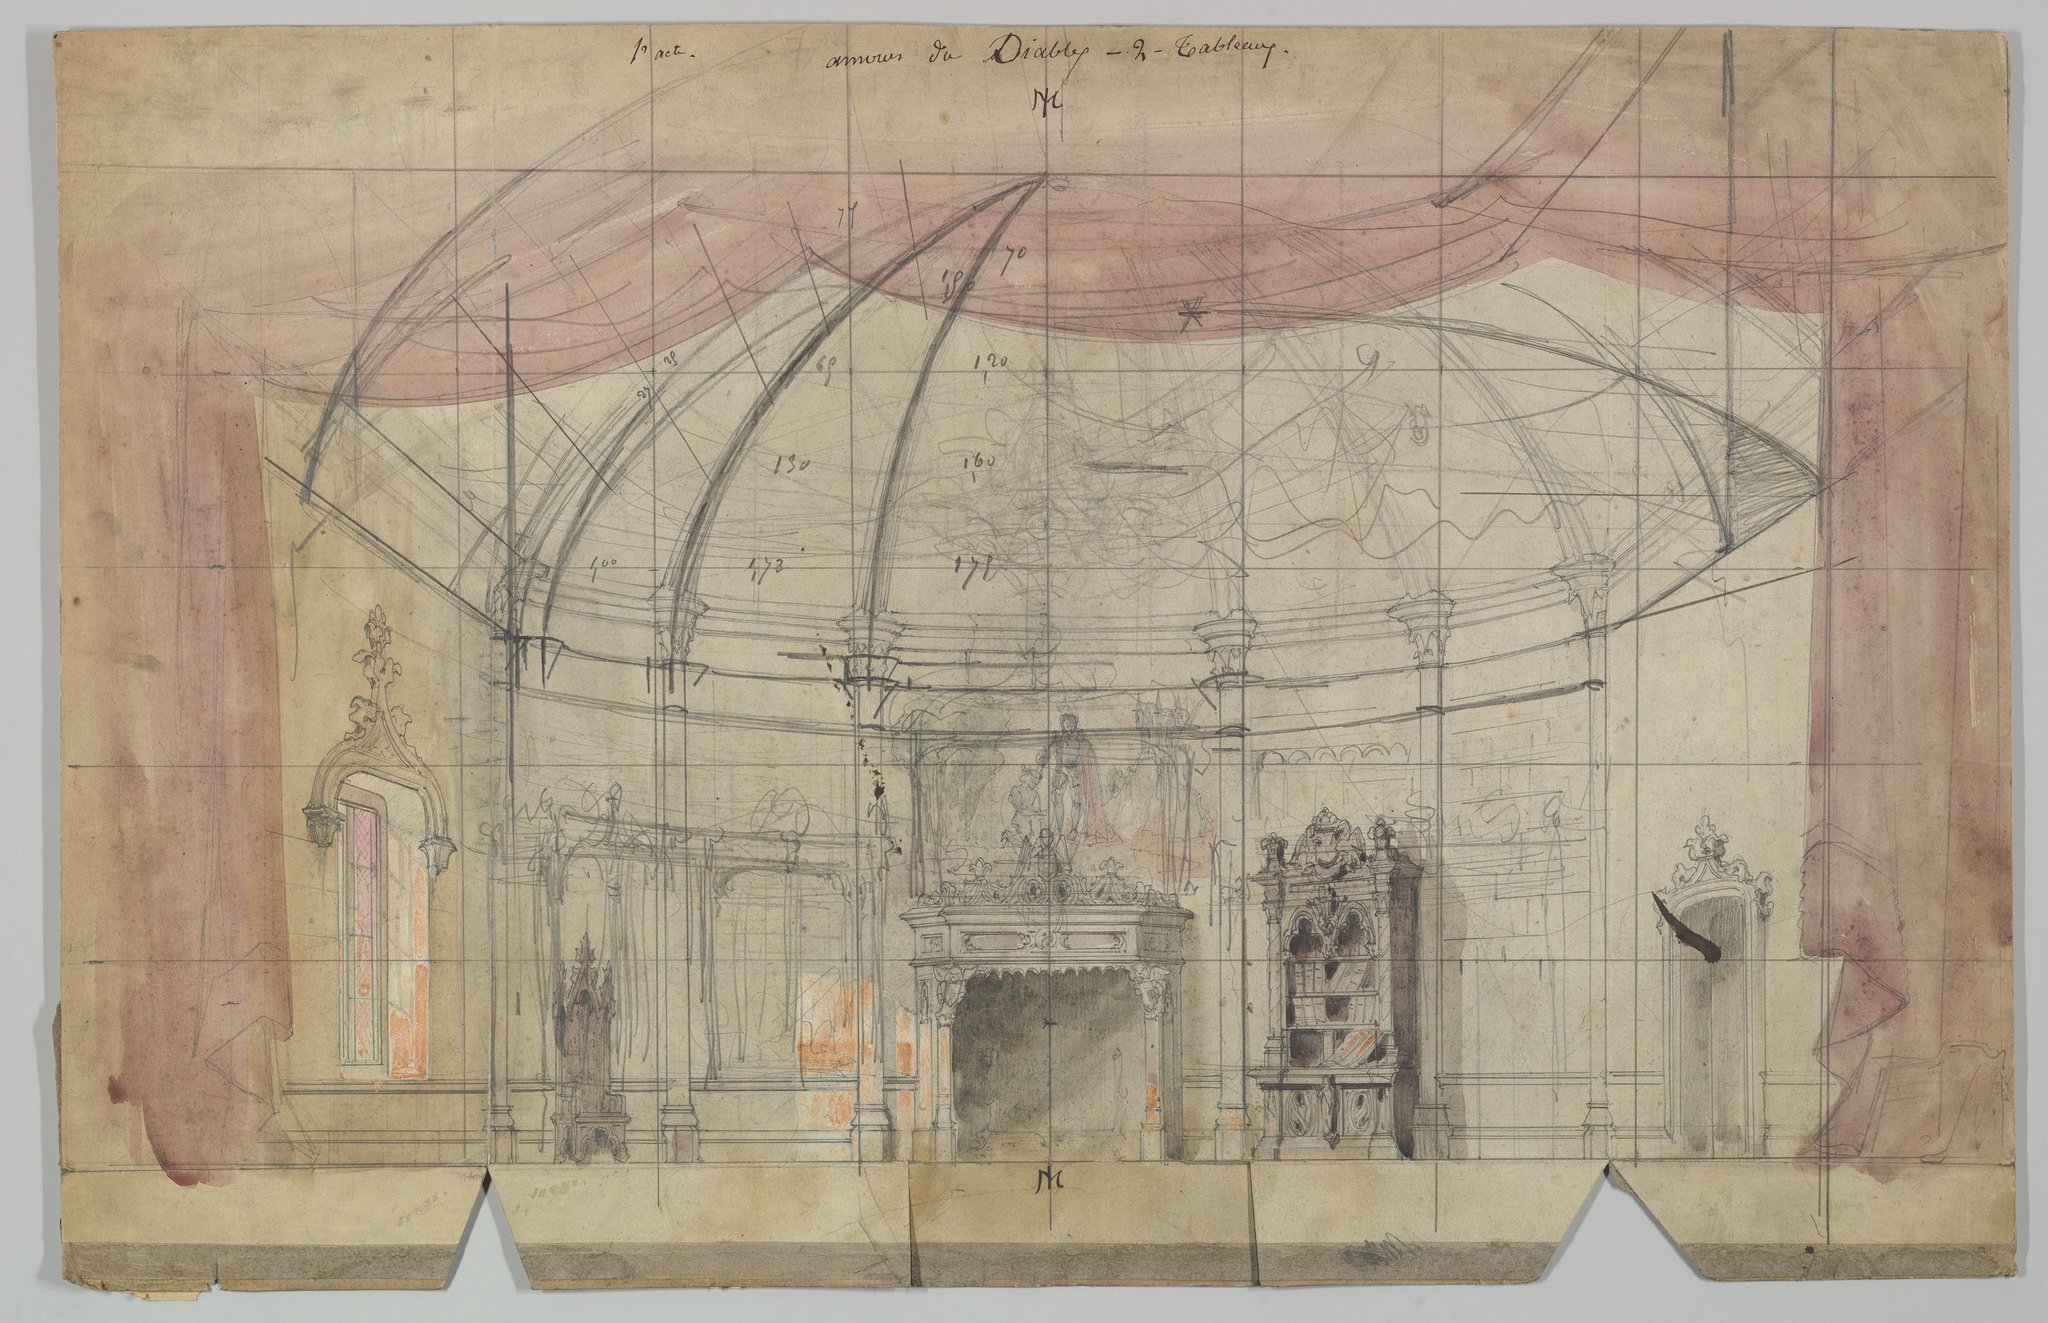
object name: drawing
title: Design for a Stage Set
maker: eugène cicéri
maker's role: artist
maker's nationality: french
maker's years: 1813-1890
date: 1830-1890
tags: theatre,stage design